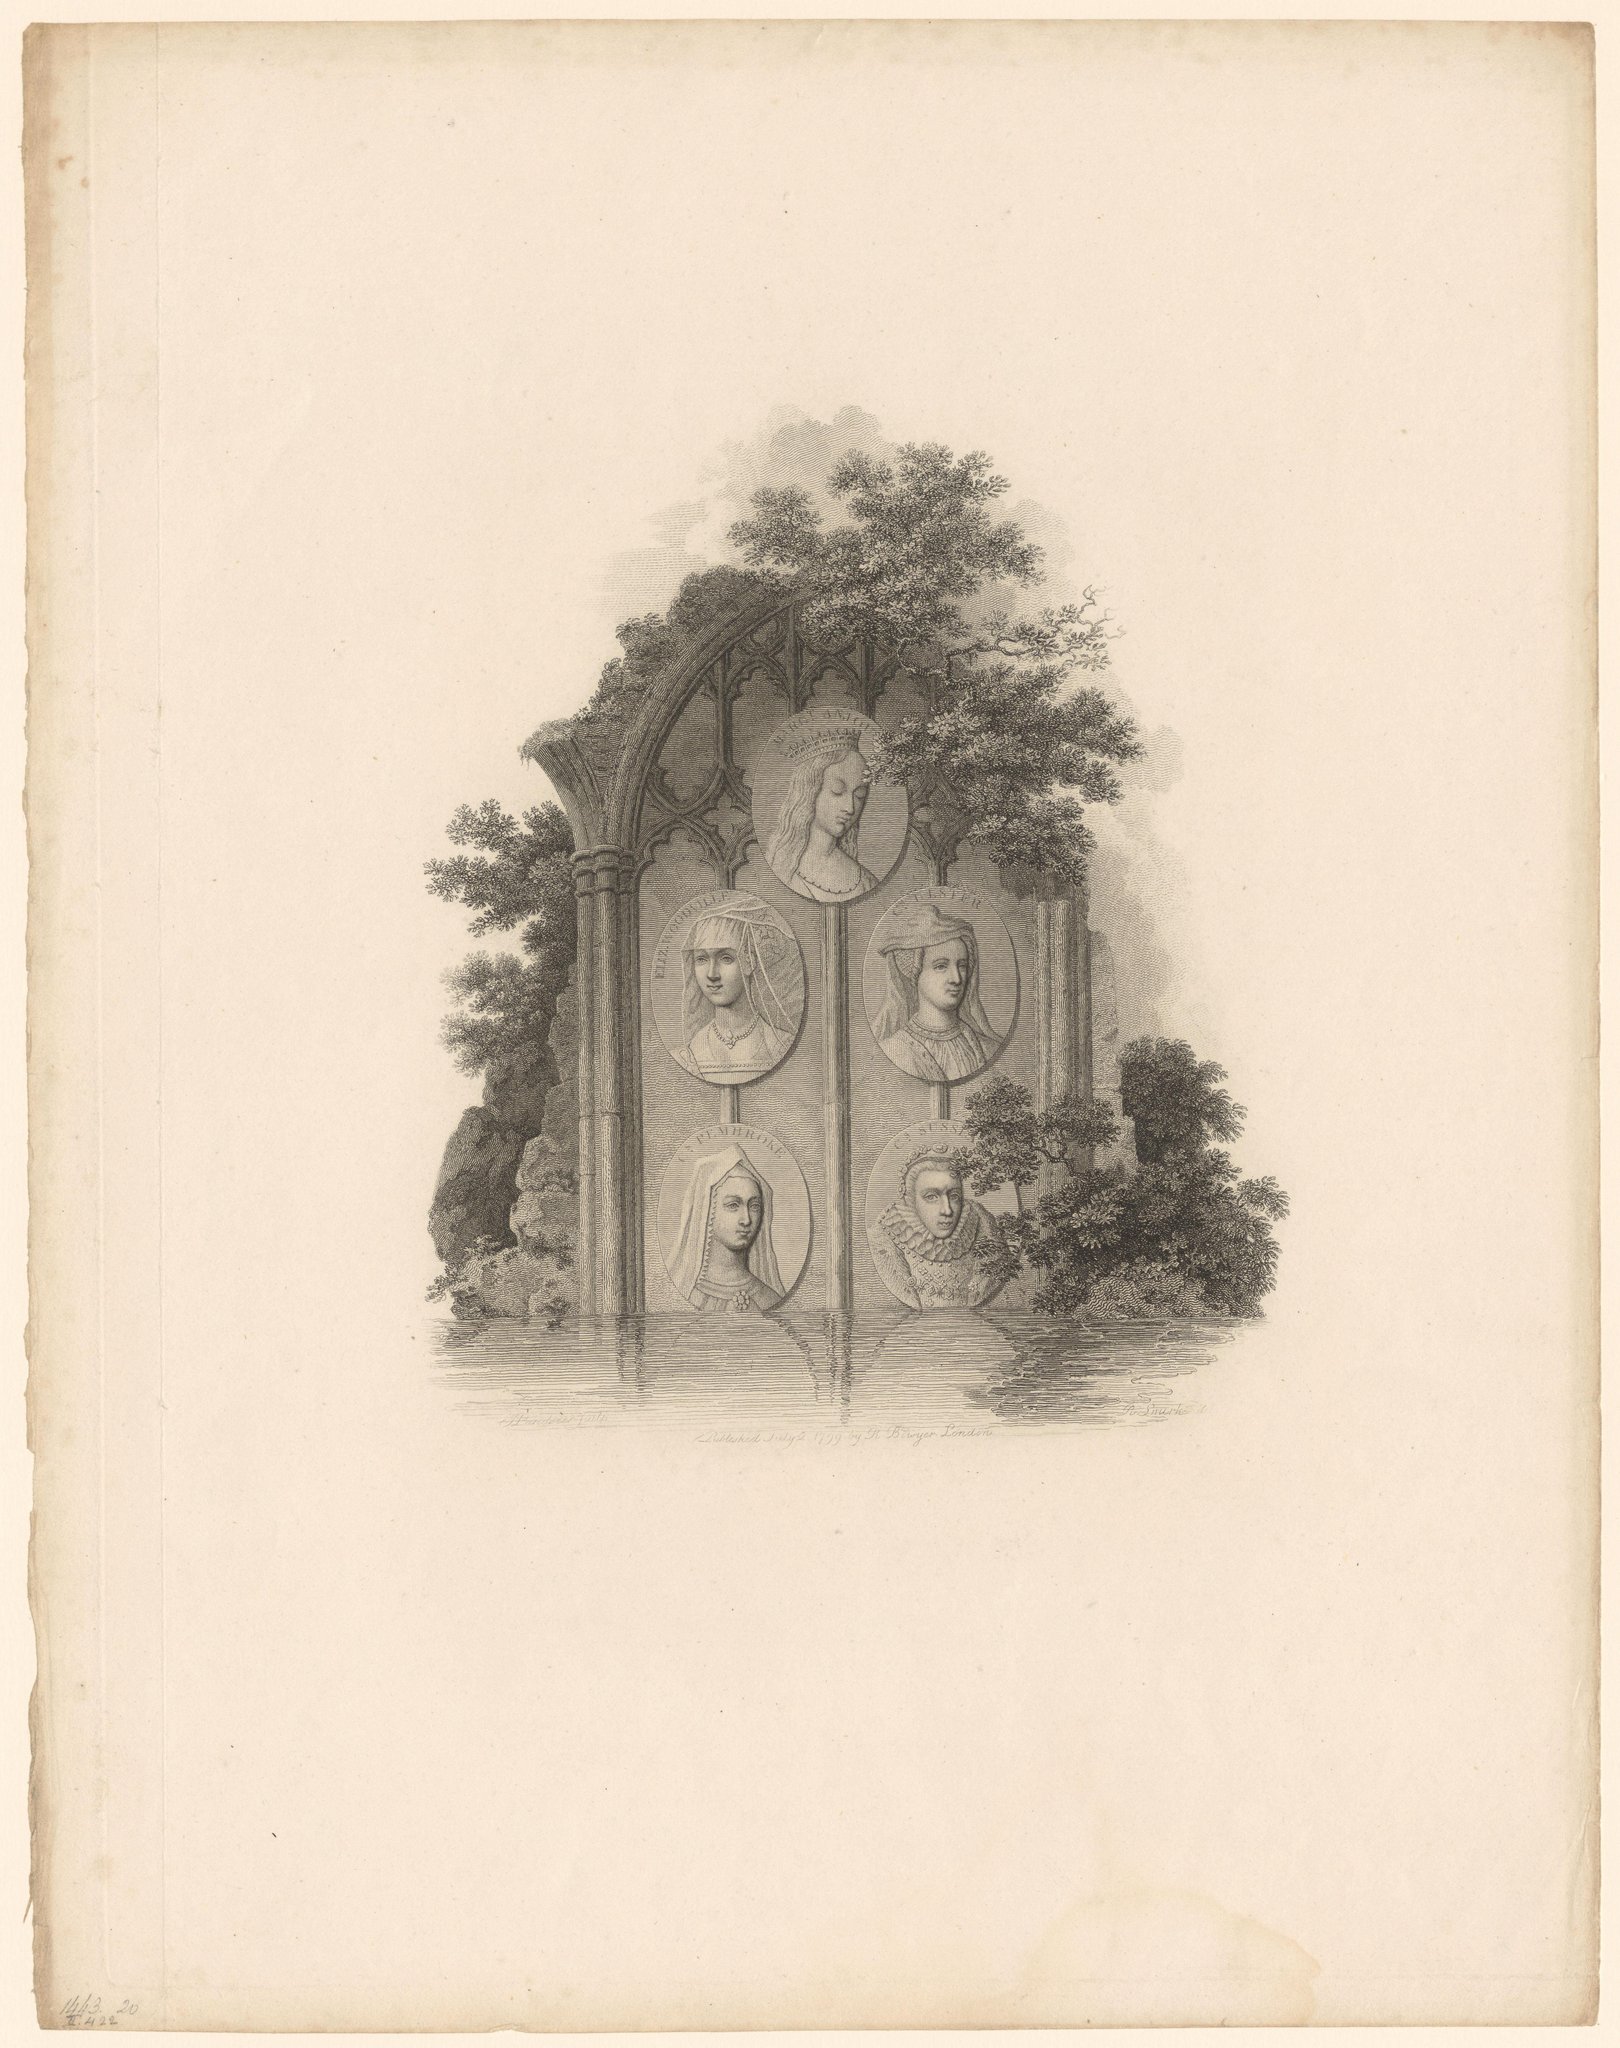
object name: print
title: Gotisch raamwerk met vijf portretten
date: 1799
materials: paper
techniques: etching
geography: london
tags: london, historical persons, queen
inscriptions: collector's mark: Lugt 2228